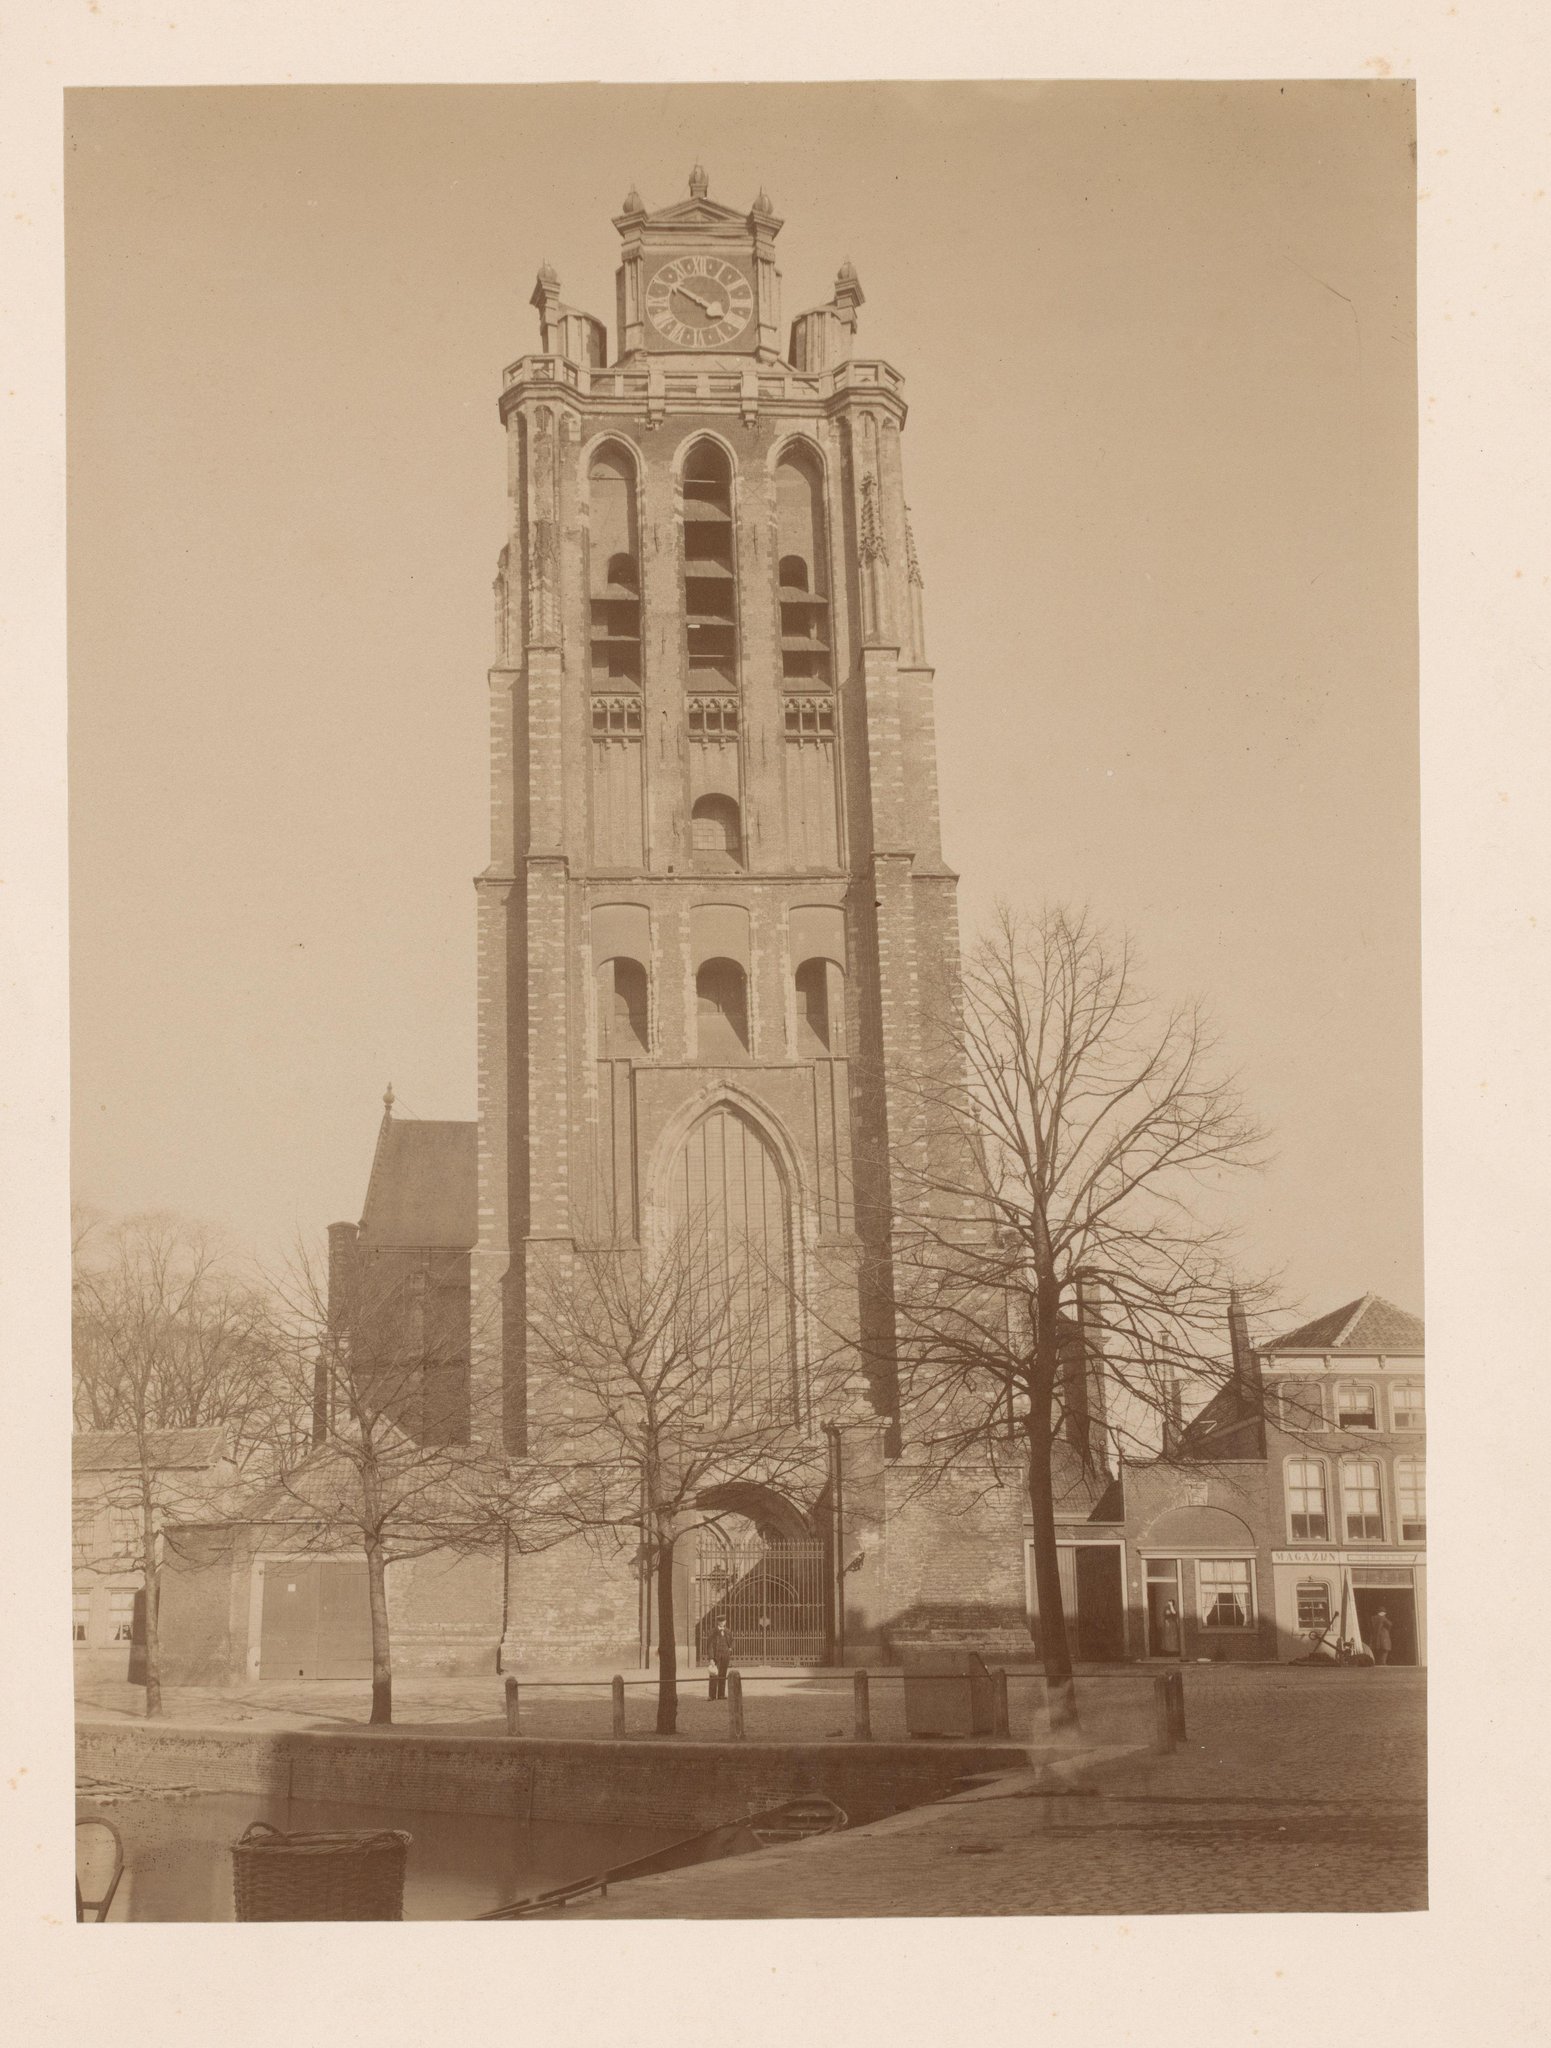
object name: photograph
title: Gezicht op de toren van de Grote of Onze-Lieve-Vrouwenkerk te Dordrecht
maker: anoniem (monumentenzorg)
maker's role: fotograaf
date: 1880-1910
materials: cardboard, photographic support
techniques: albumen print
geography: korte geldersekade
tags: church (exterior)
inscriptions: annotation: ‘Toren van de N.H. Groote Kerk/ Dordrecht’, annotation: ‘Dordrecht toren’